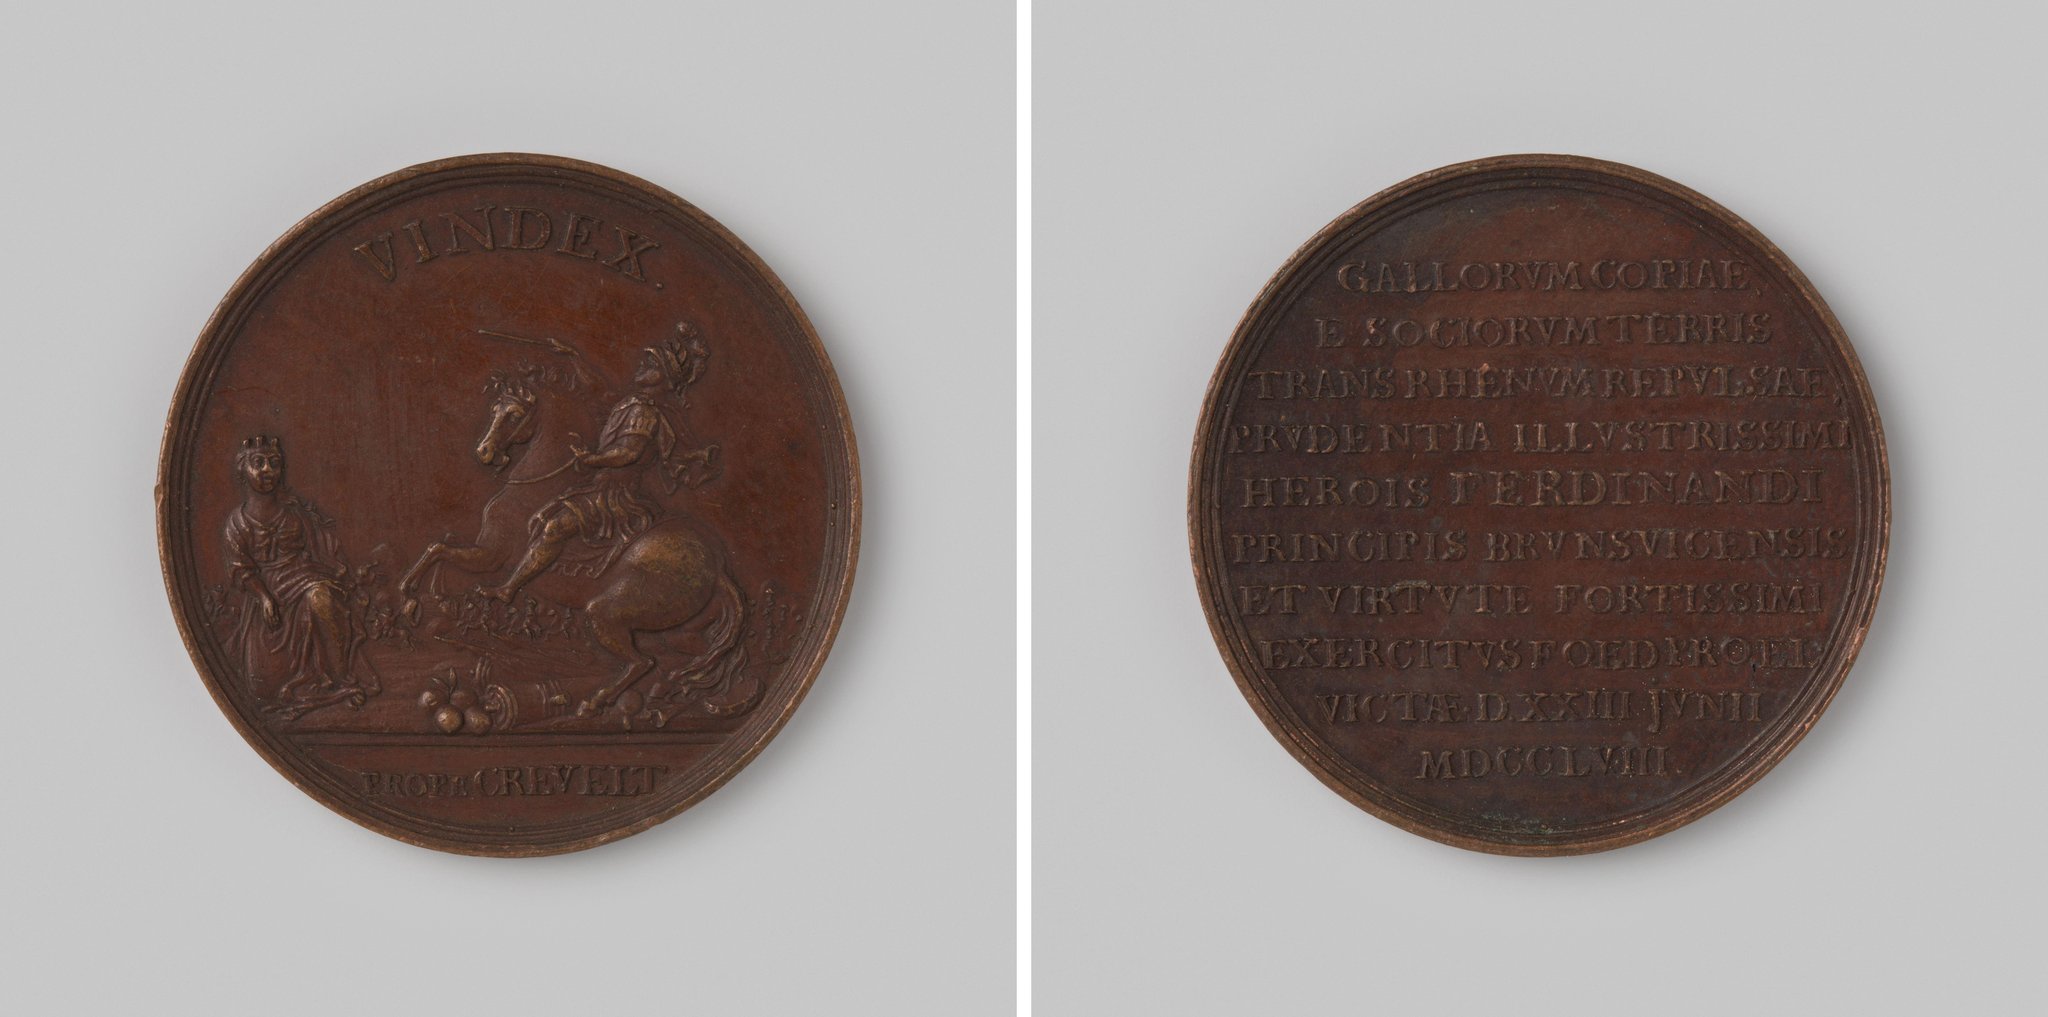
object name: history medal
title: Overwinning bij Krefeld op de Fransen door Ferdinand, hertog van Brunswijk-Wolfenbuttel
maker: Anonymous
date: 1758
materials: bronze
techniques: striking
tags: wolfenbüttel, militair, hertog, ferdinand hertog van brunswijk-wolfenbüttel, krefeld, zevenjarige oorlog, slag bij krefeld